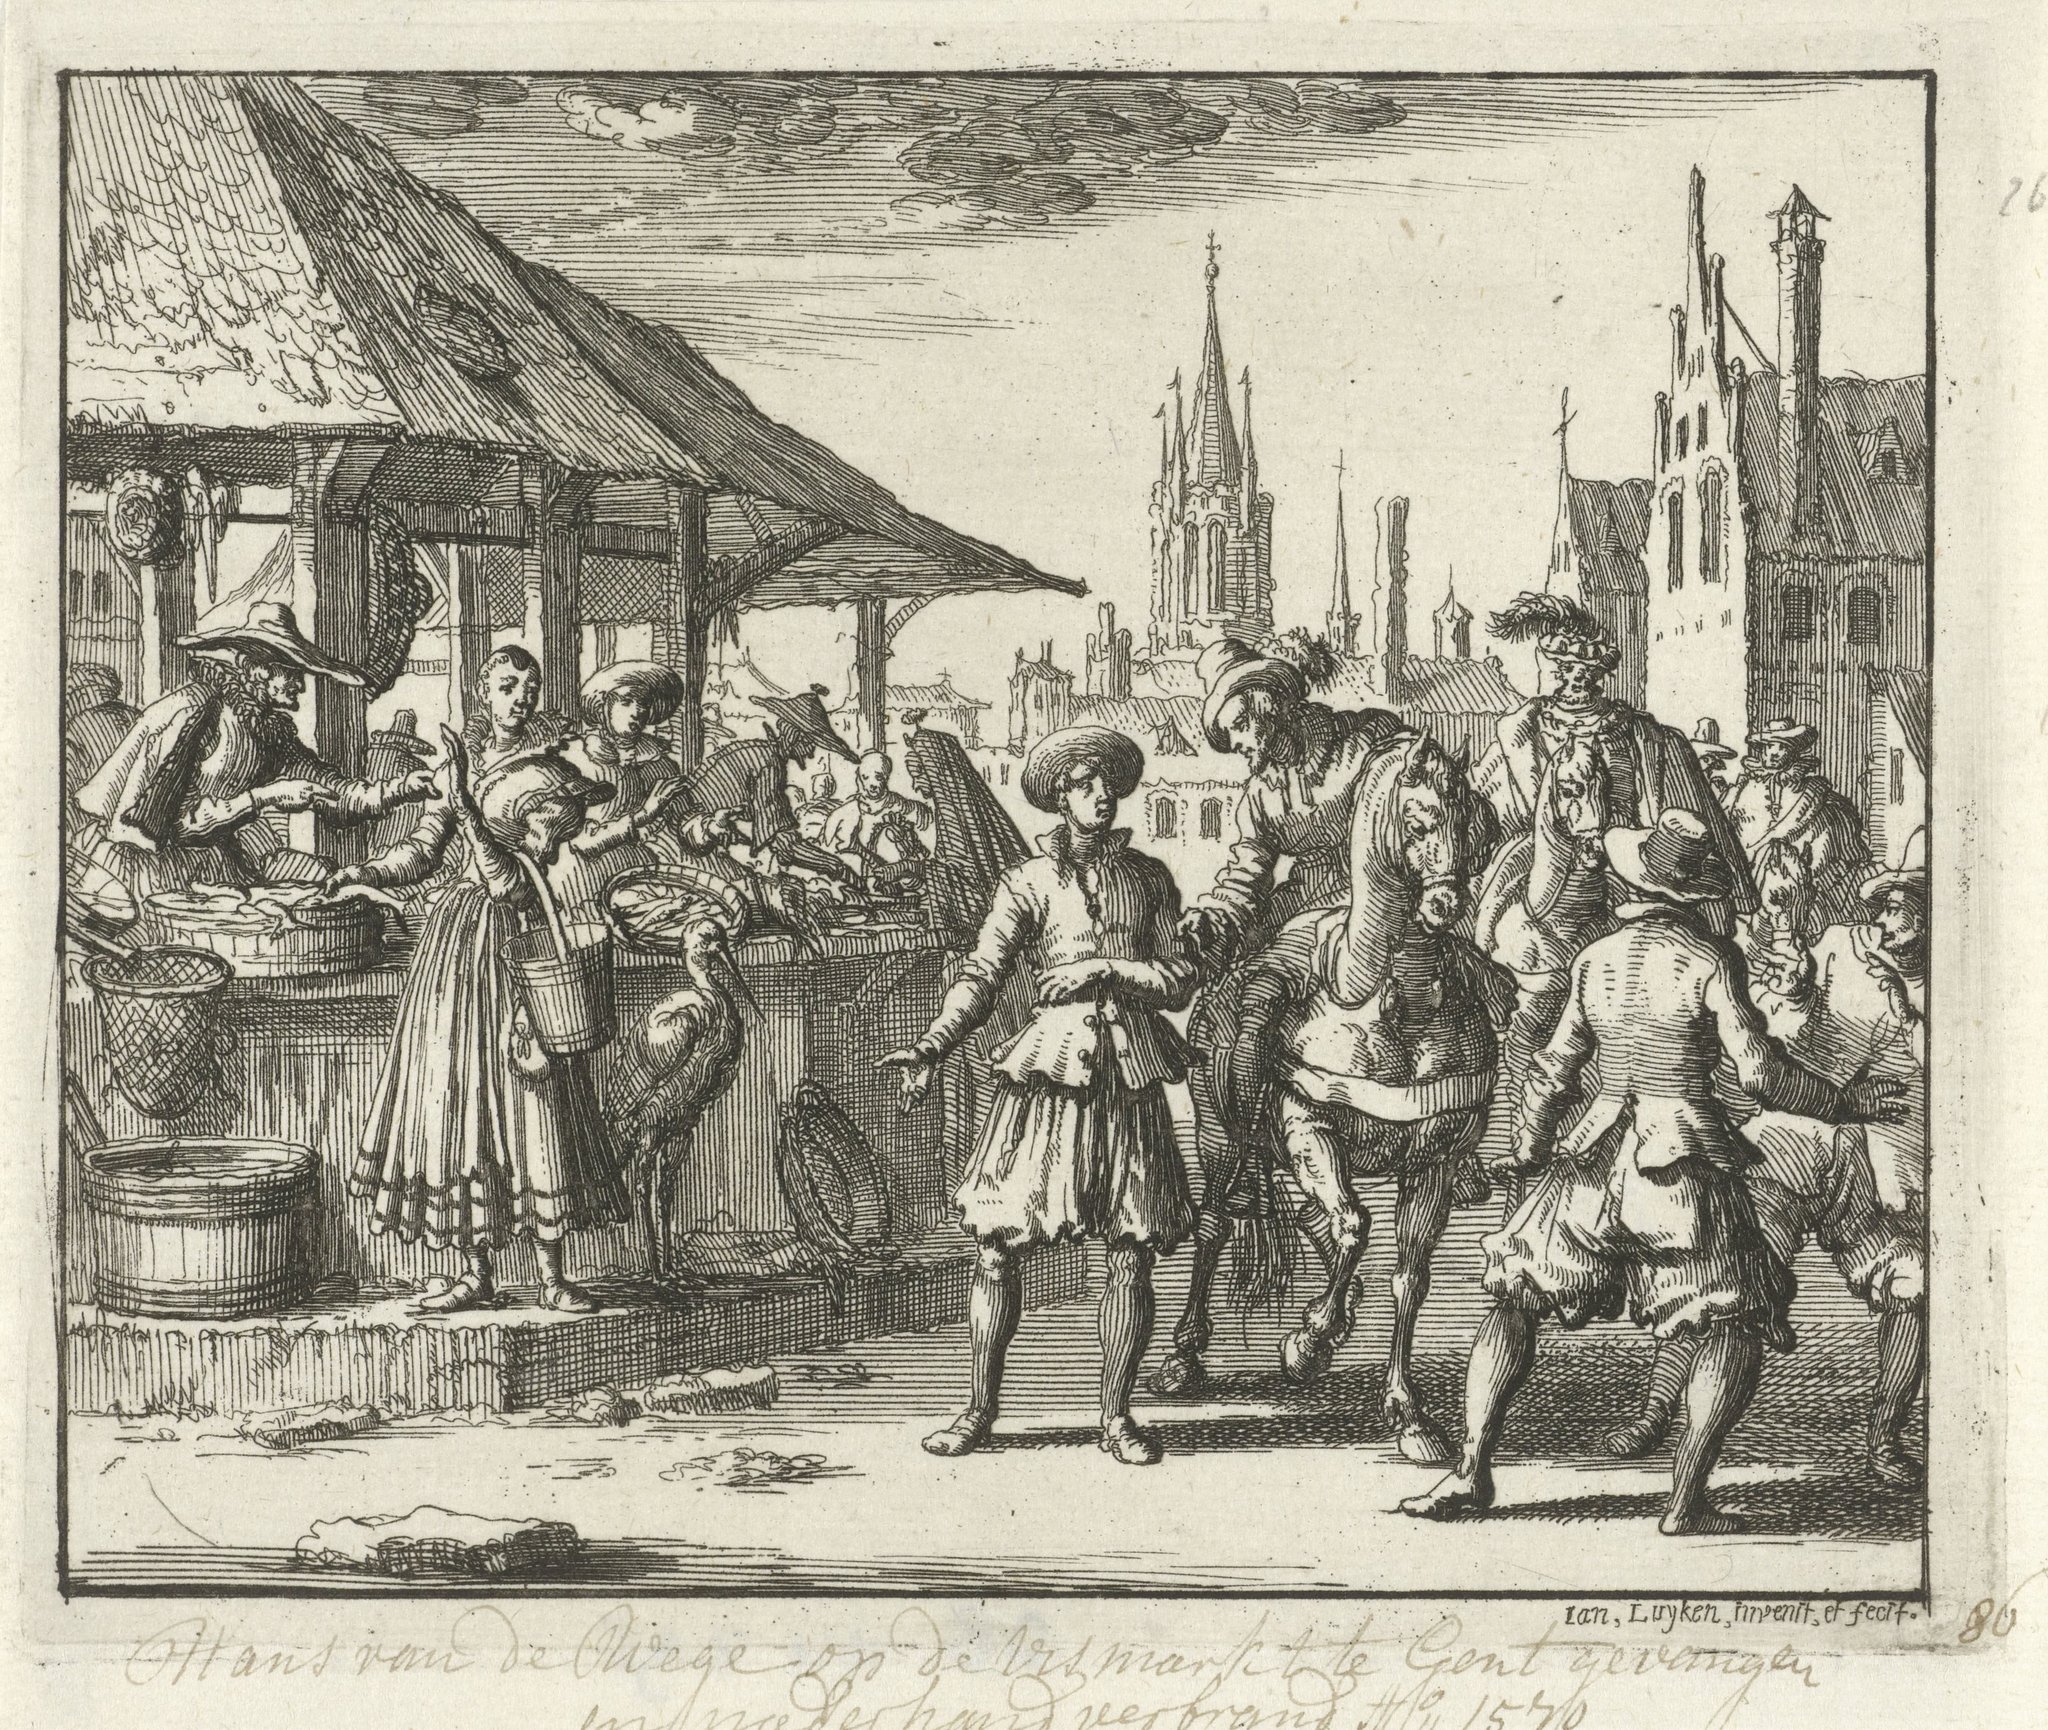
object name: book illustration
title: Arrestatie van Hans van der Wege op de Vismarkt te Gent, 1570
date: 1685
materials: paper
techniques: etching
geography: amsterdam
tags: ghent, arrest (of criminal)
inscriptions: collector's mark: Lugt 2228, number: ‘86’, inscription: ‘Hans van [...] Ao 1570’